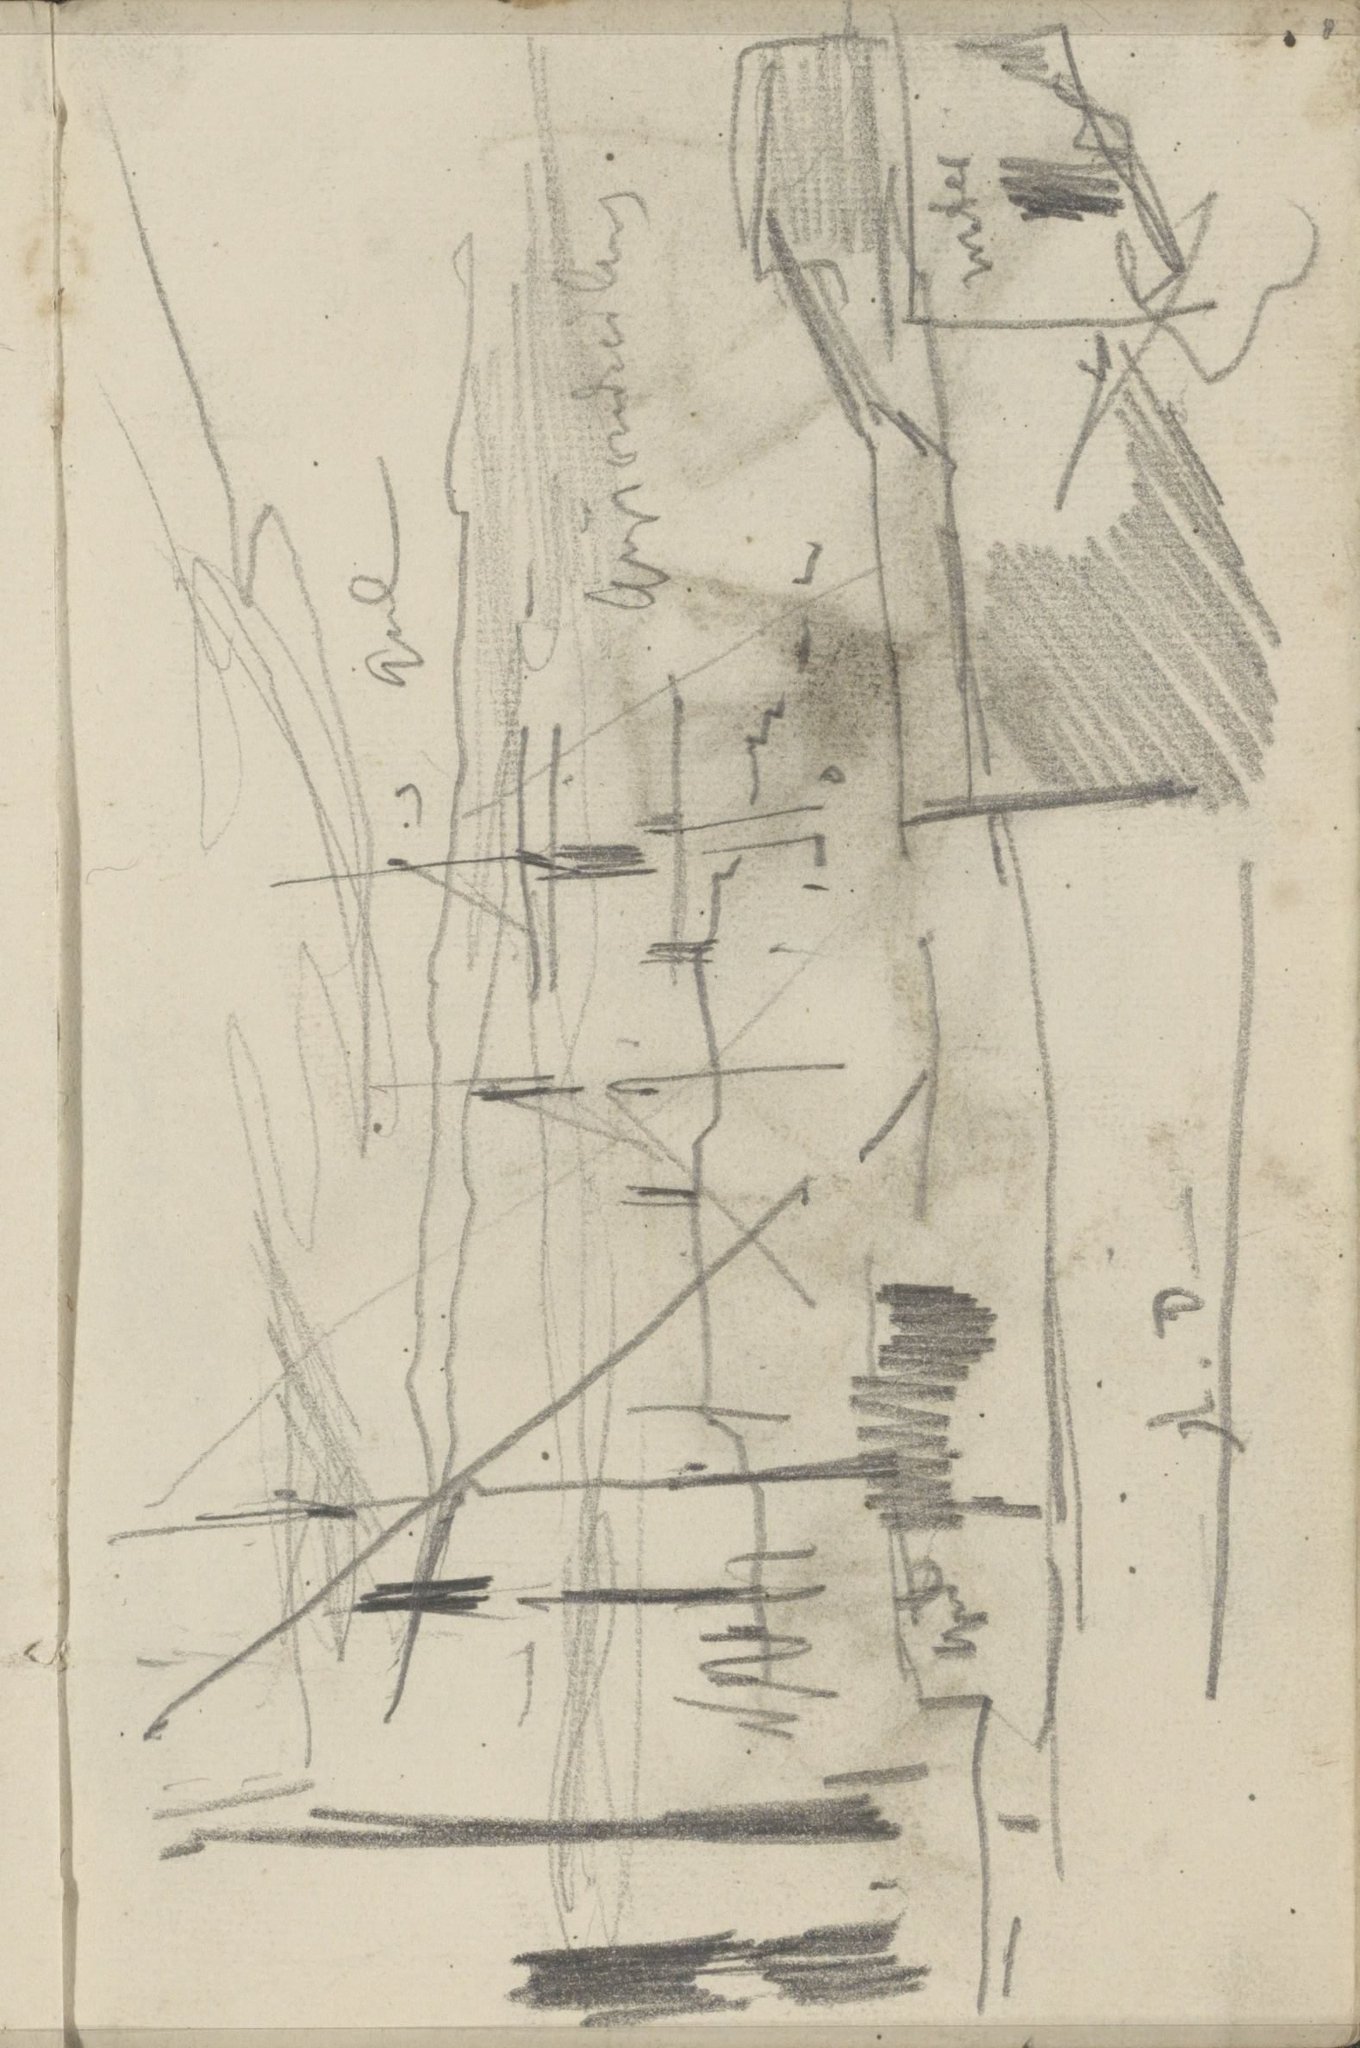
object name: sketchbook leaf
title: Gezicht in Amsterdam met schepen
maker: george hendrik breitner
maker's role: draughtsman, painter, print maker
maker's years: 1857-1923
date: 1886-1898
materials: paper, pencil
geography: amsterdam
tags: ships (in general), canals, waters (in city), amsterdam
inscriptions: kleurnotitie, handgeschreven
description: Pagina 8 uit een schetsboek met 18 bladen.